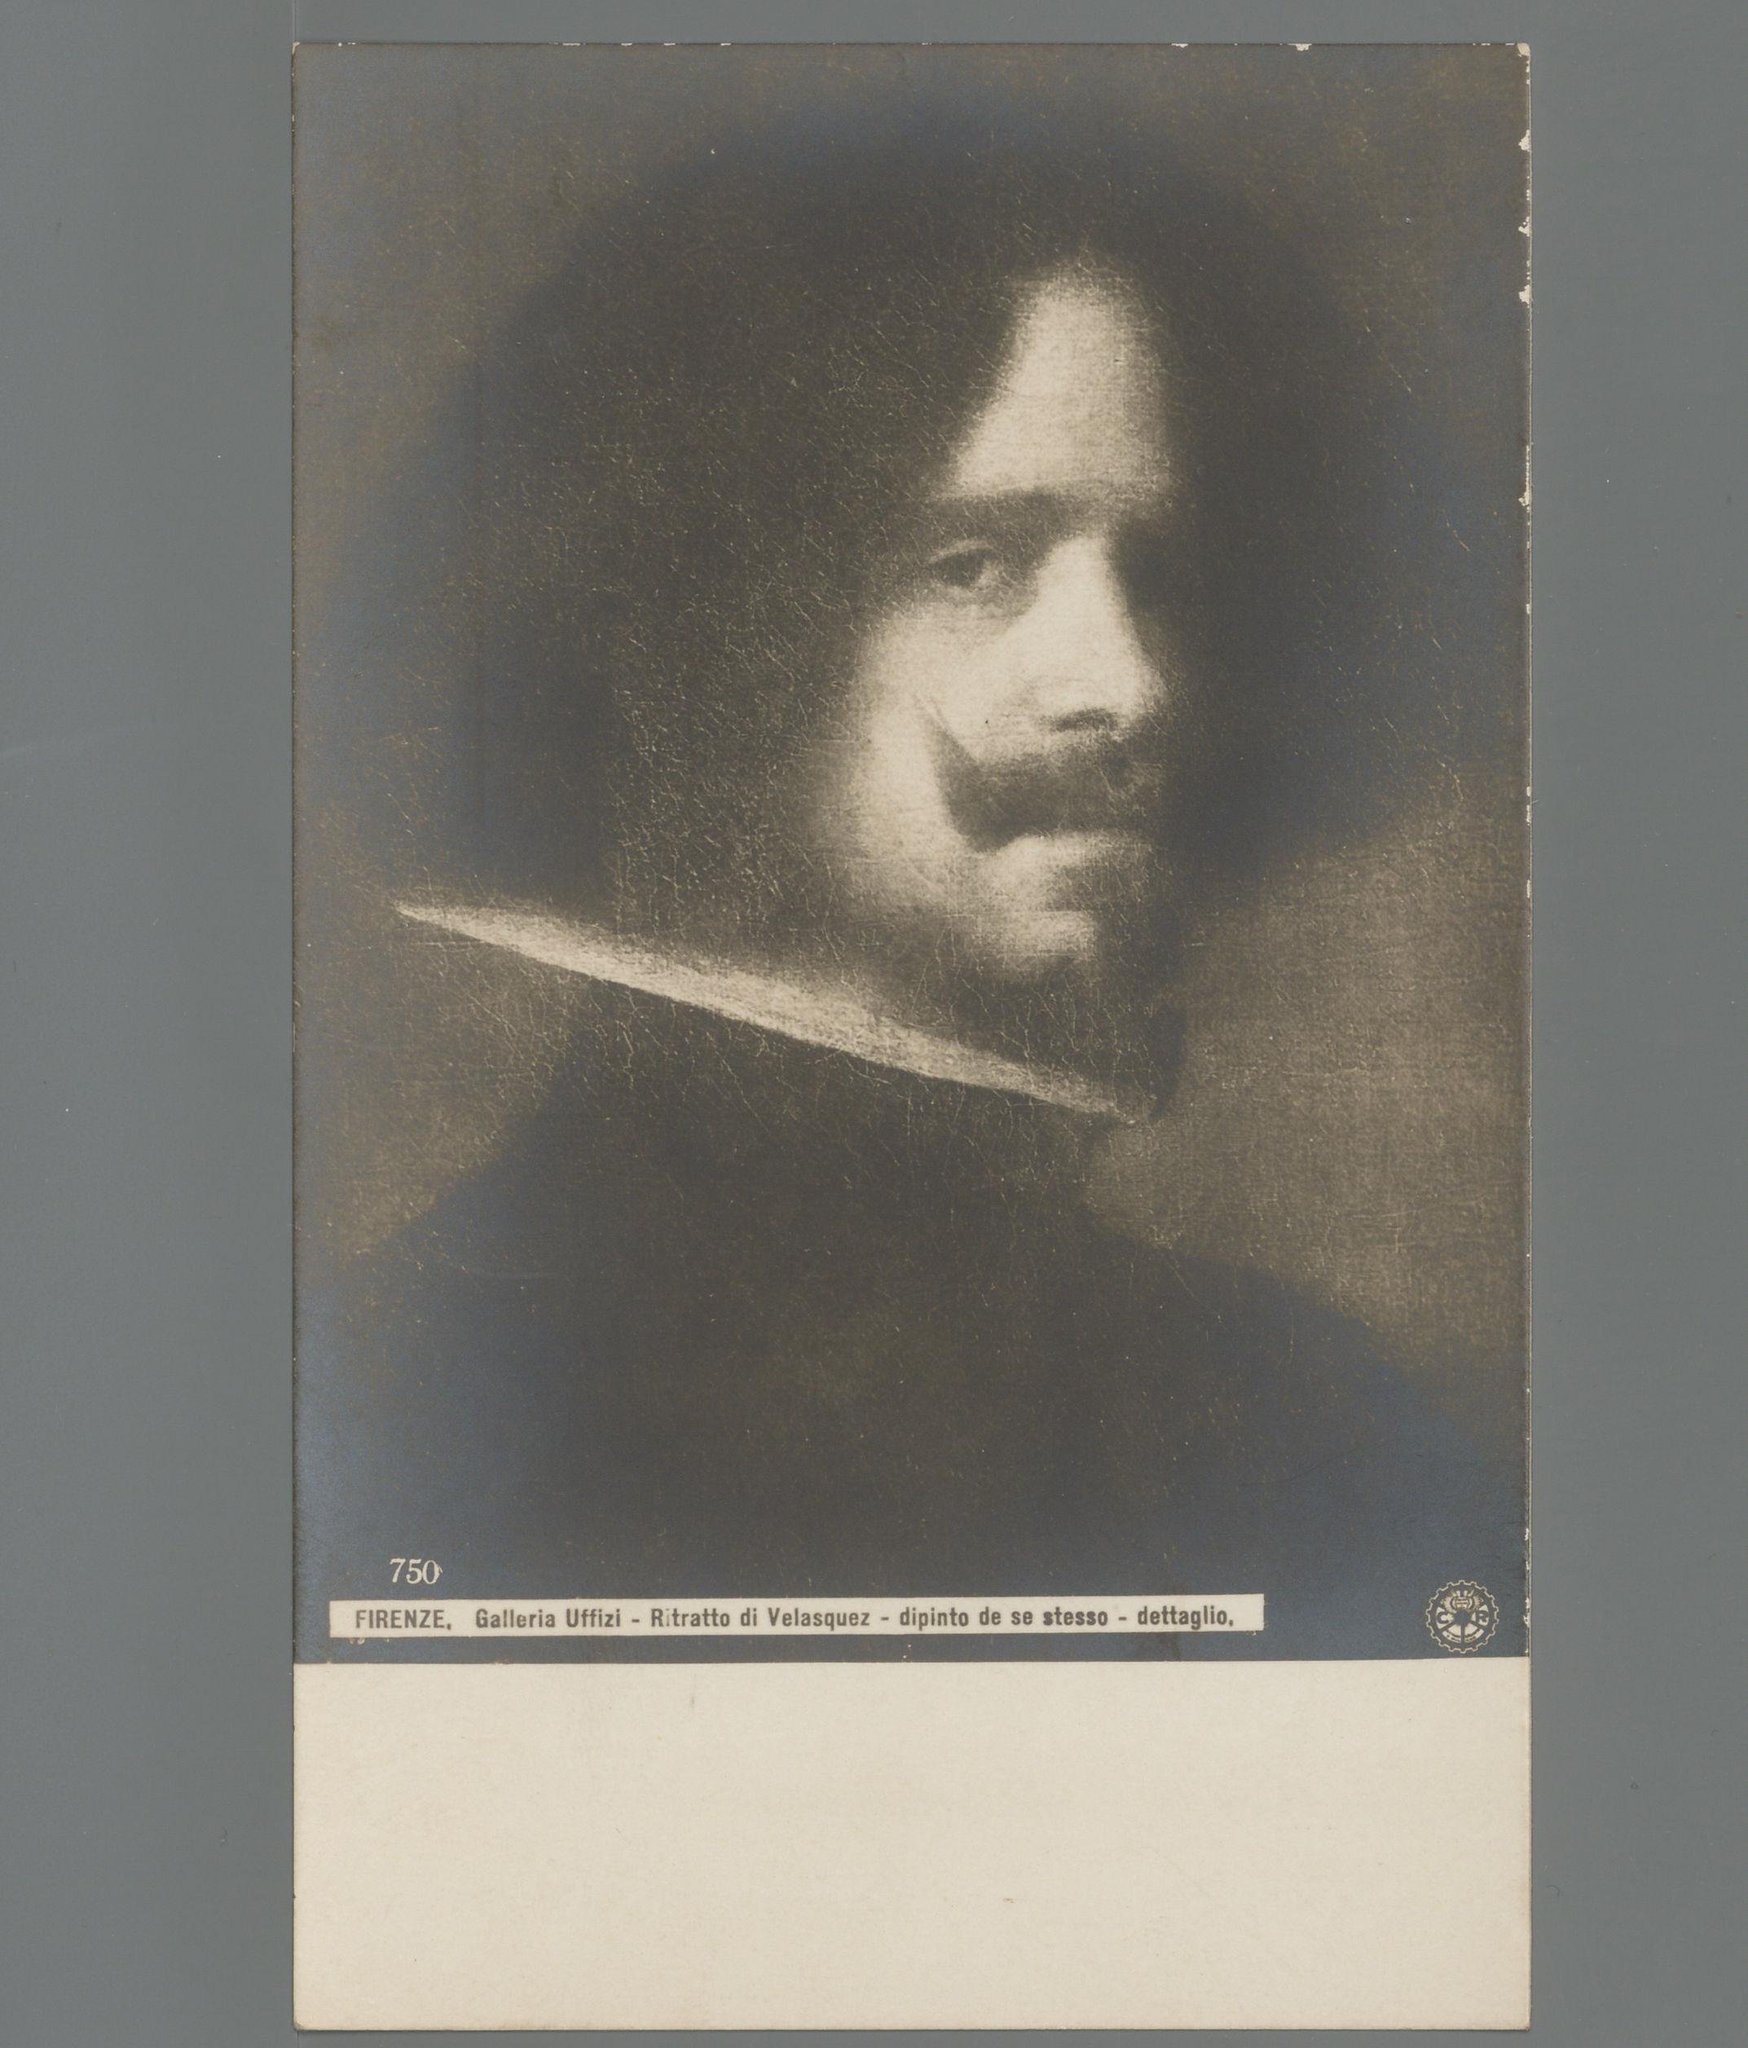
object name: photograph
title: Firenze. Galleria Uffizi. Ritratto di Velasquez. Dipinto de se stesso. Dettaglio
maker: diego rodriguez de silva y velázquez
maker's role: painter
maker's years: 1599-1660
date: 1906-1930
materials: photographic support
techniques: photography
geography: florence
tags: sevilla, painter, diego rodriguez de silva y velázquez, portrait, self-portrait of artist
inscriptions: collector's mark: ‘AFE v S’